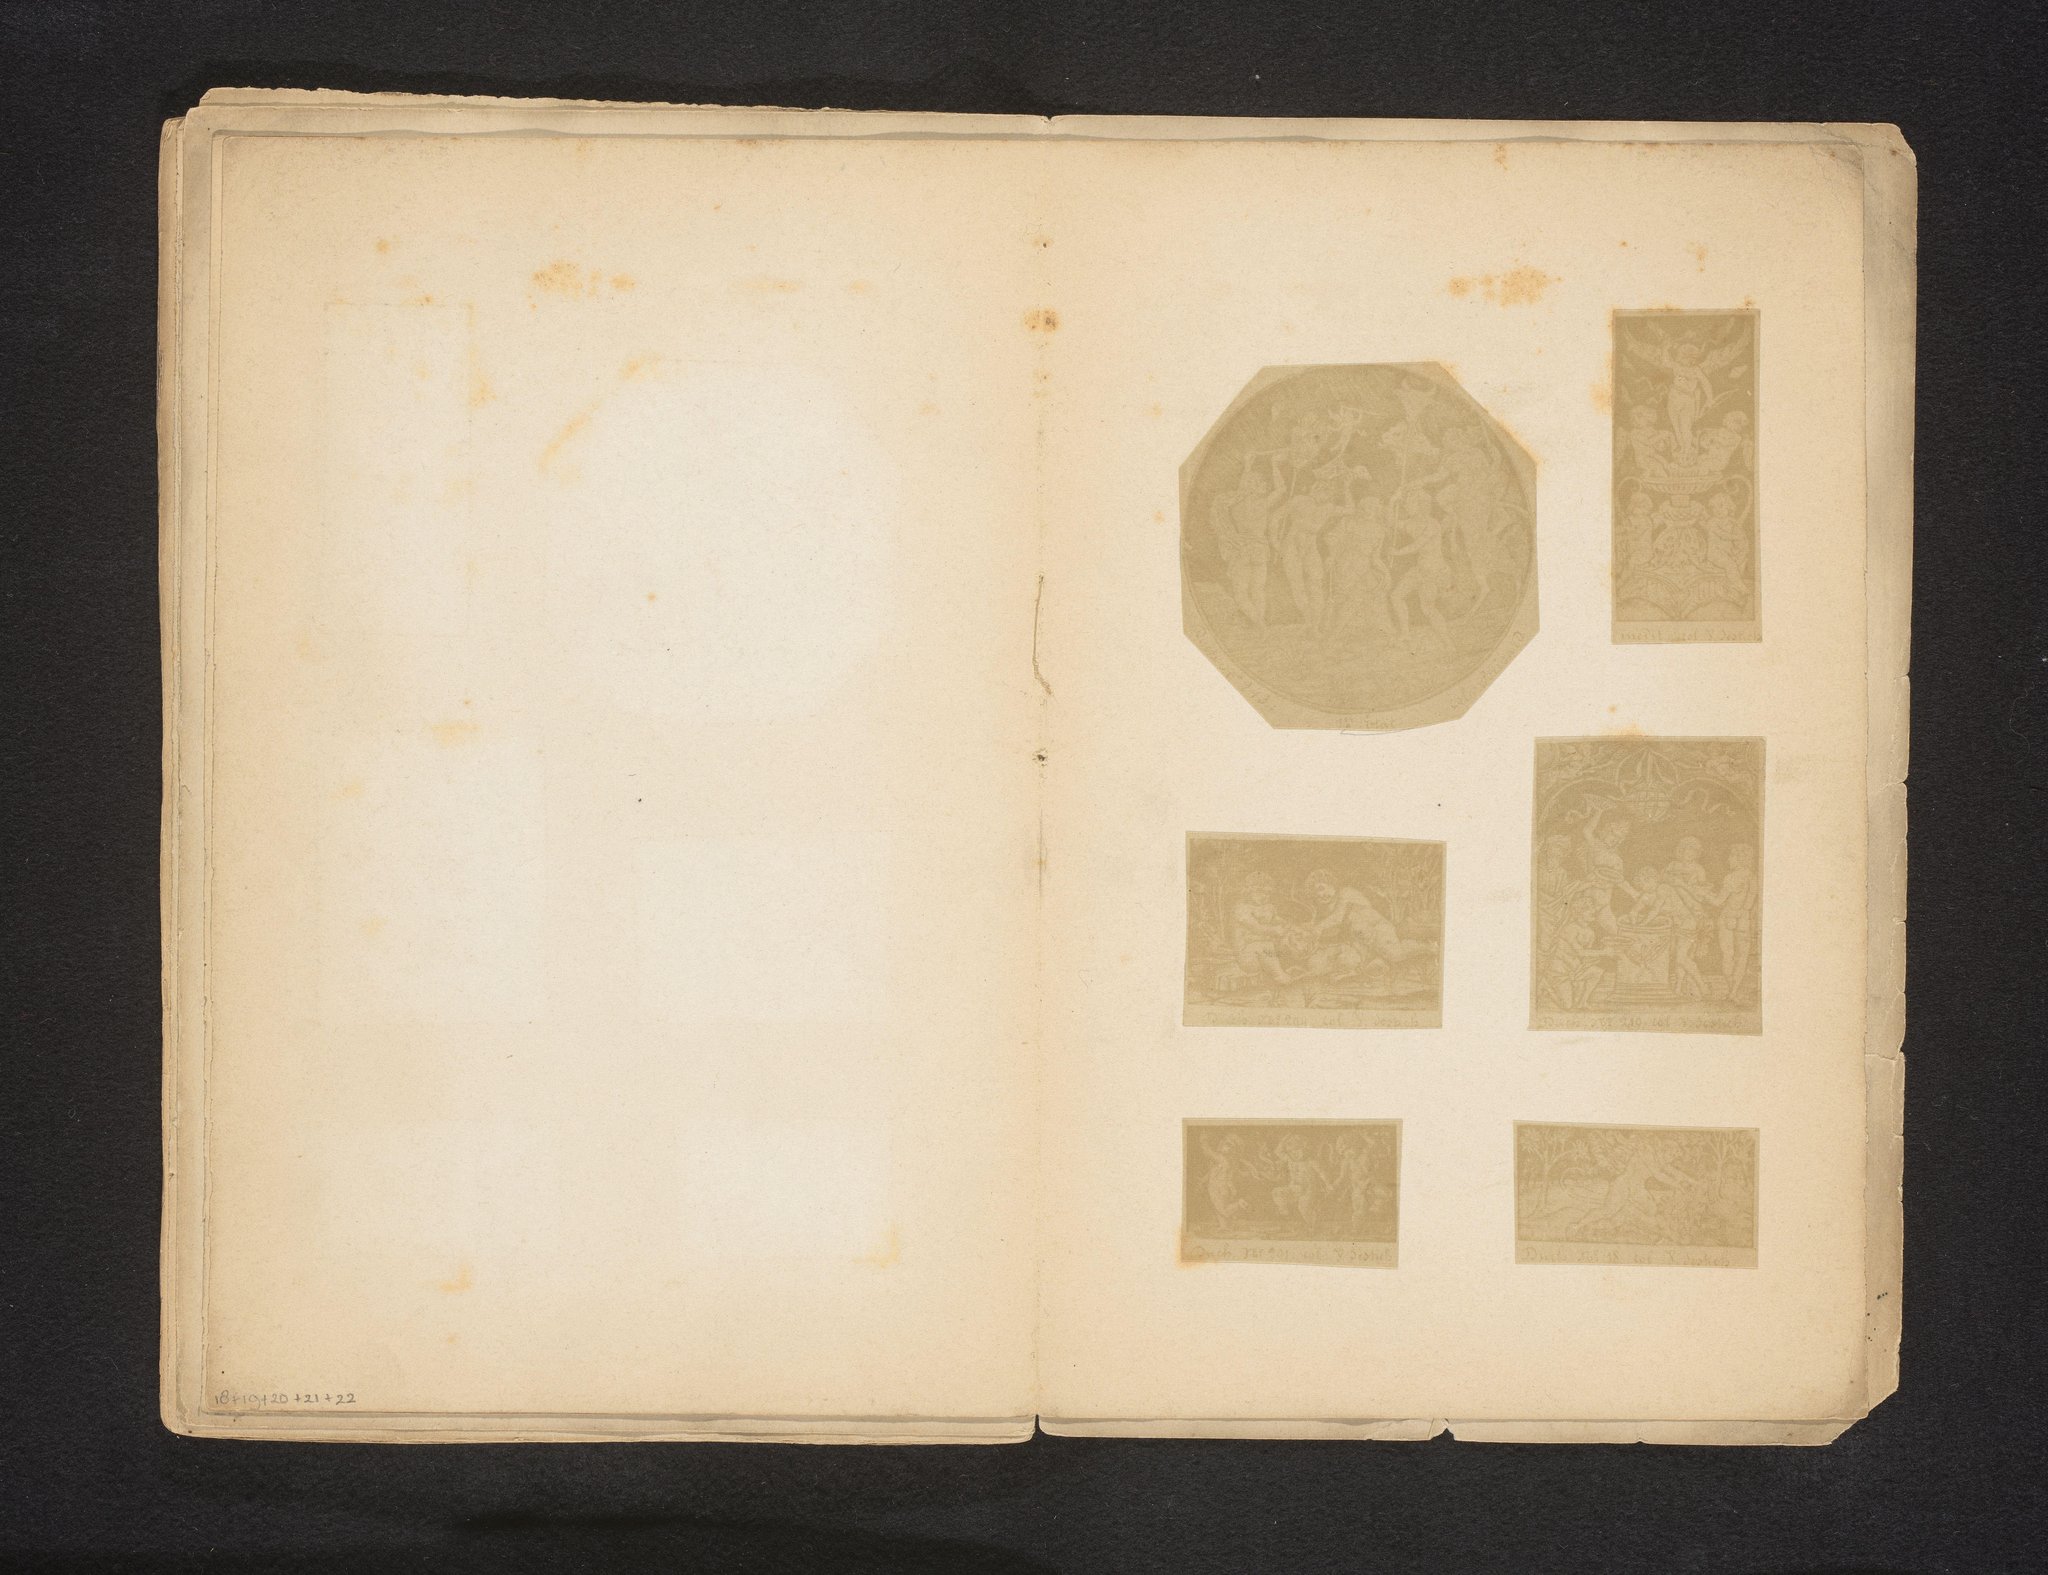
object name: photograph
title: Fotoreproductie van een prent van een bacchanaal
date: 1852-1857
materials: photographic support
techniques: salted paper print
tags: bacchanal: bacchus with his wine-flushed train (thiasos)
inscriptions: inscription: ‘Duch. No 219. col. V. Sestich’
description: Foto op blad met zes foto's op negende ongenummerde pagina na pagina 60.